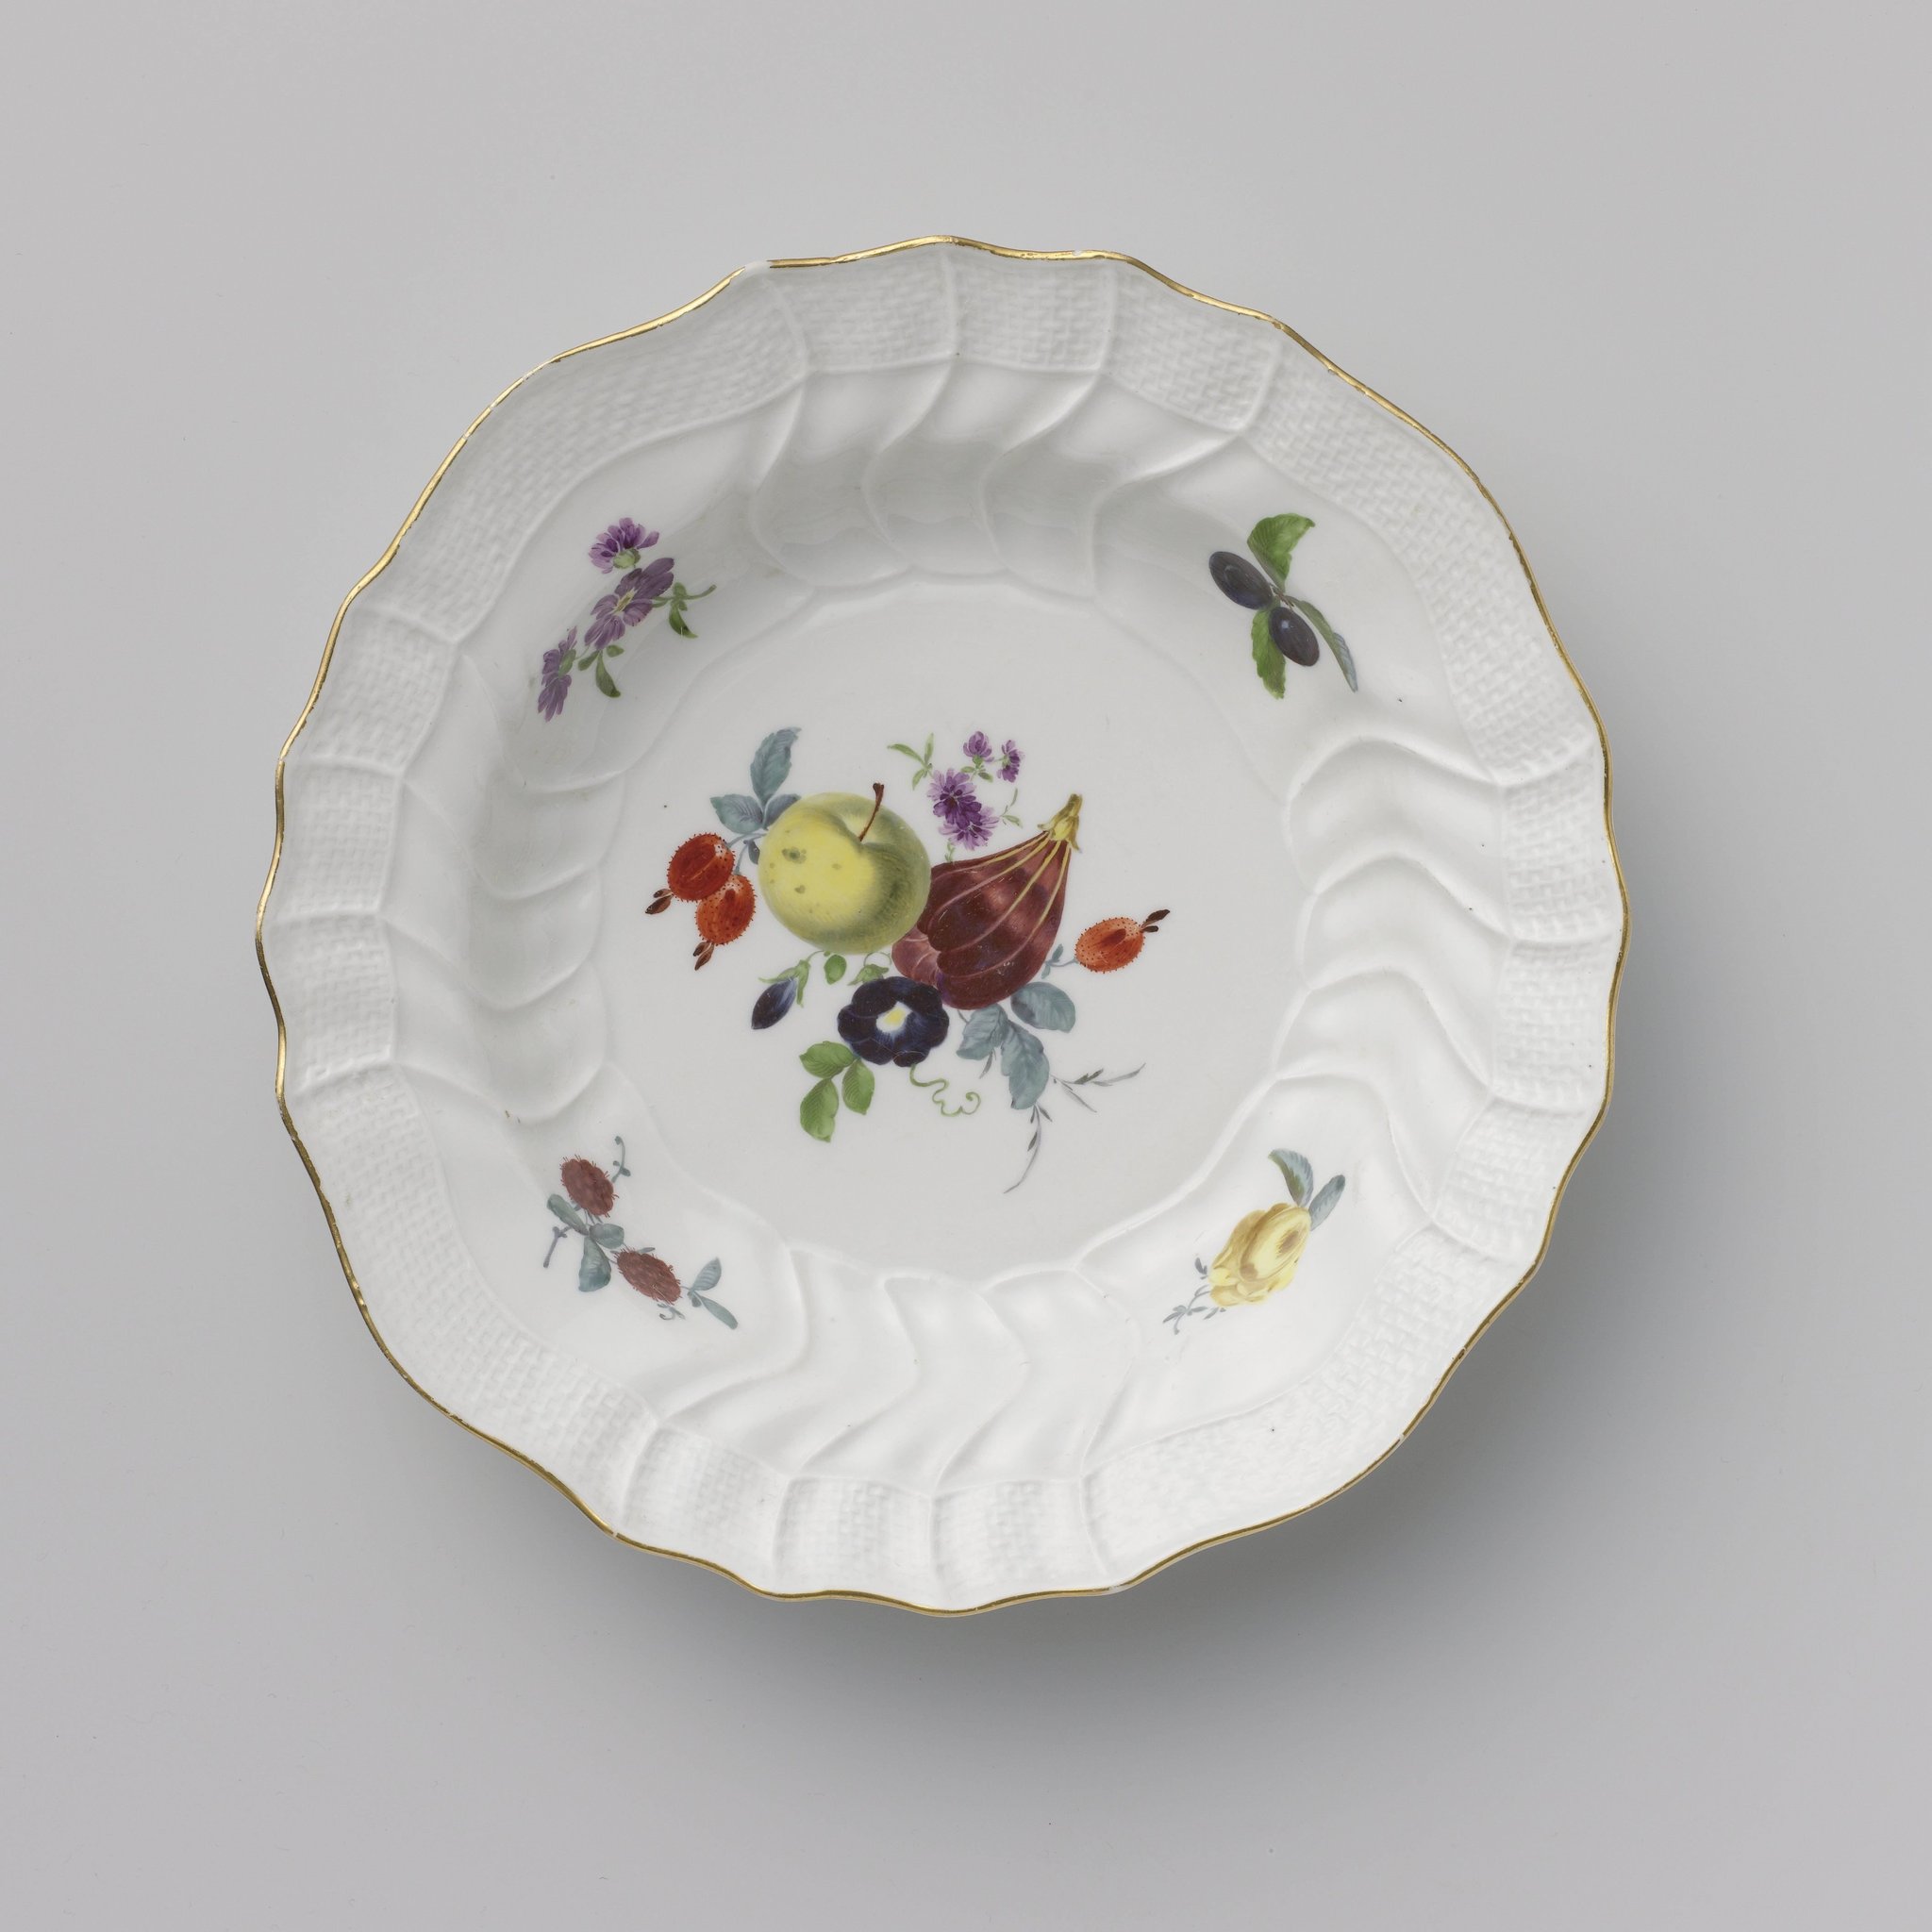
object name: plate dish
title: Bord, veelkleurig beschilderd met Deutsche Blumen, insekten en vruchten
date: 1750-1760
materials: porcelain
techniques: painted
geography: meissen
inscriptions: factory mark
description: Rond soepbord van beschilderd porselein. Het bord is beschilderd met Deutsche Blumen, insekten en vruchten. De rand is in reliëf versierd met het Neuozier-patroon. Het bord is gemerkt en hoort bij een servies (BK-17474-1 t/m BK-17474-253).